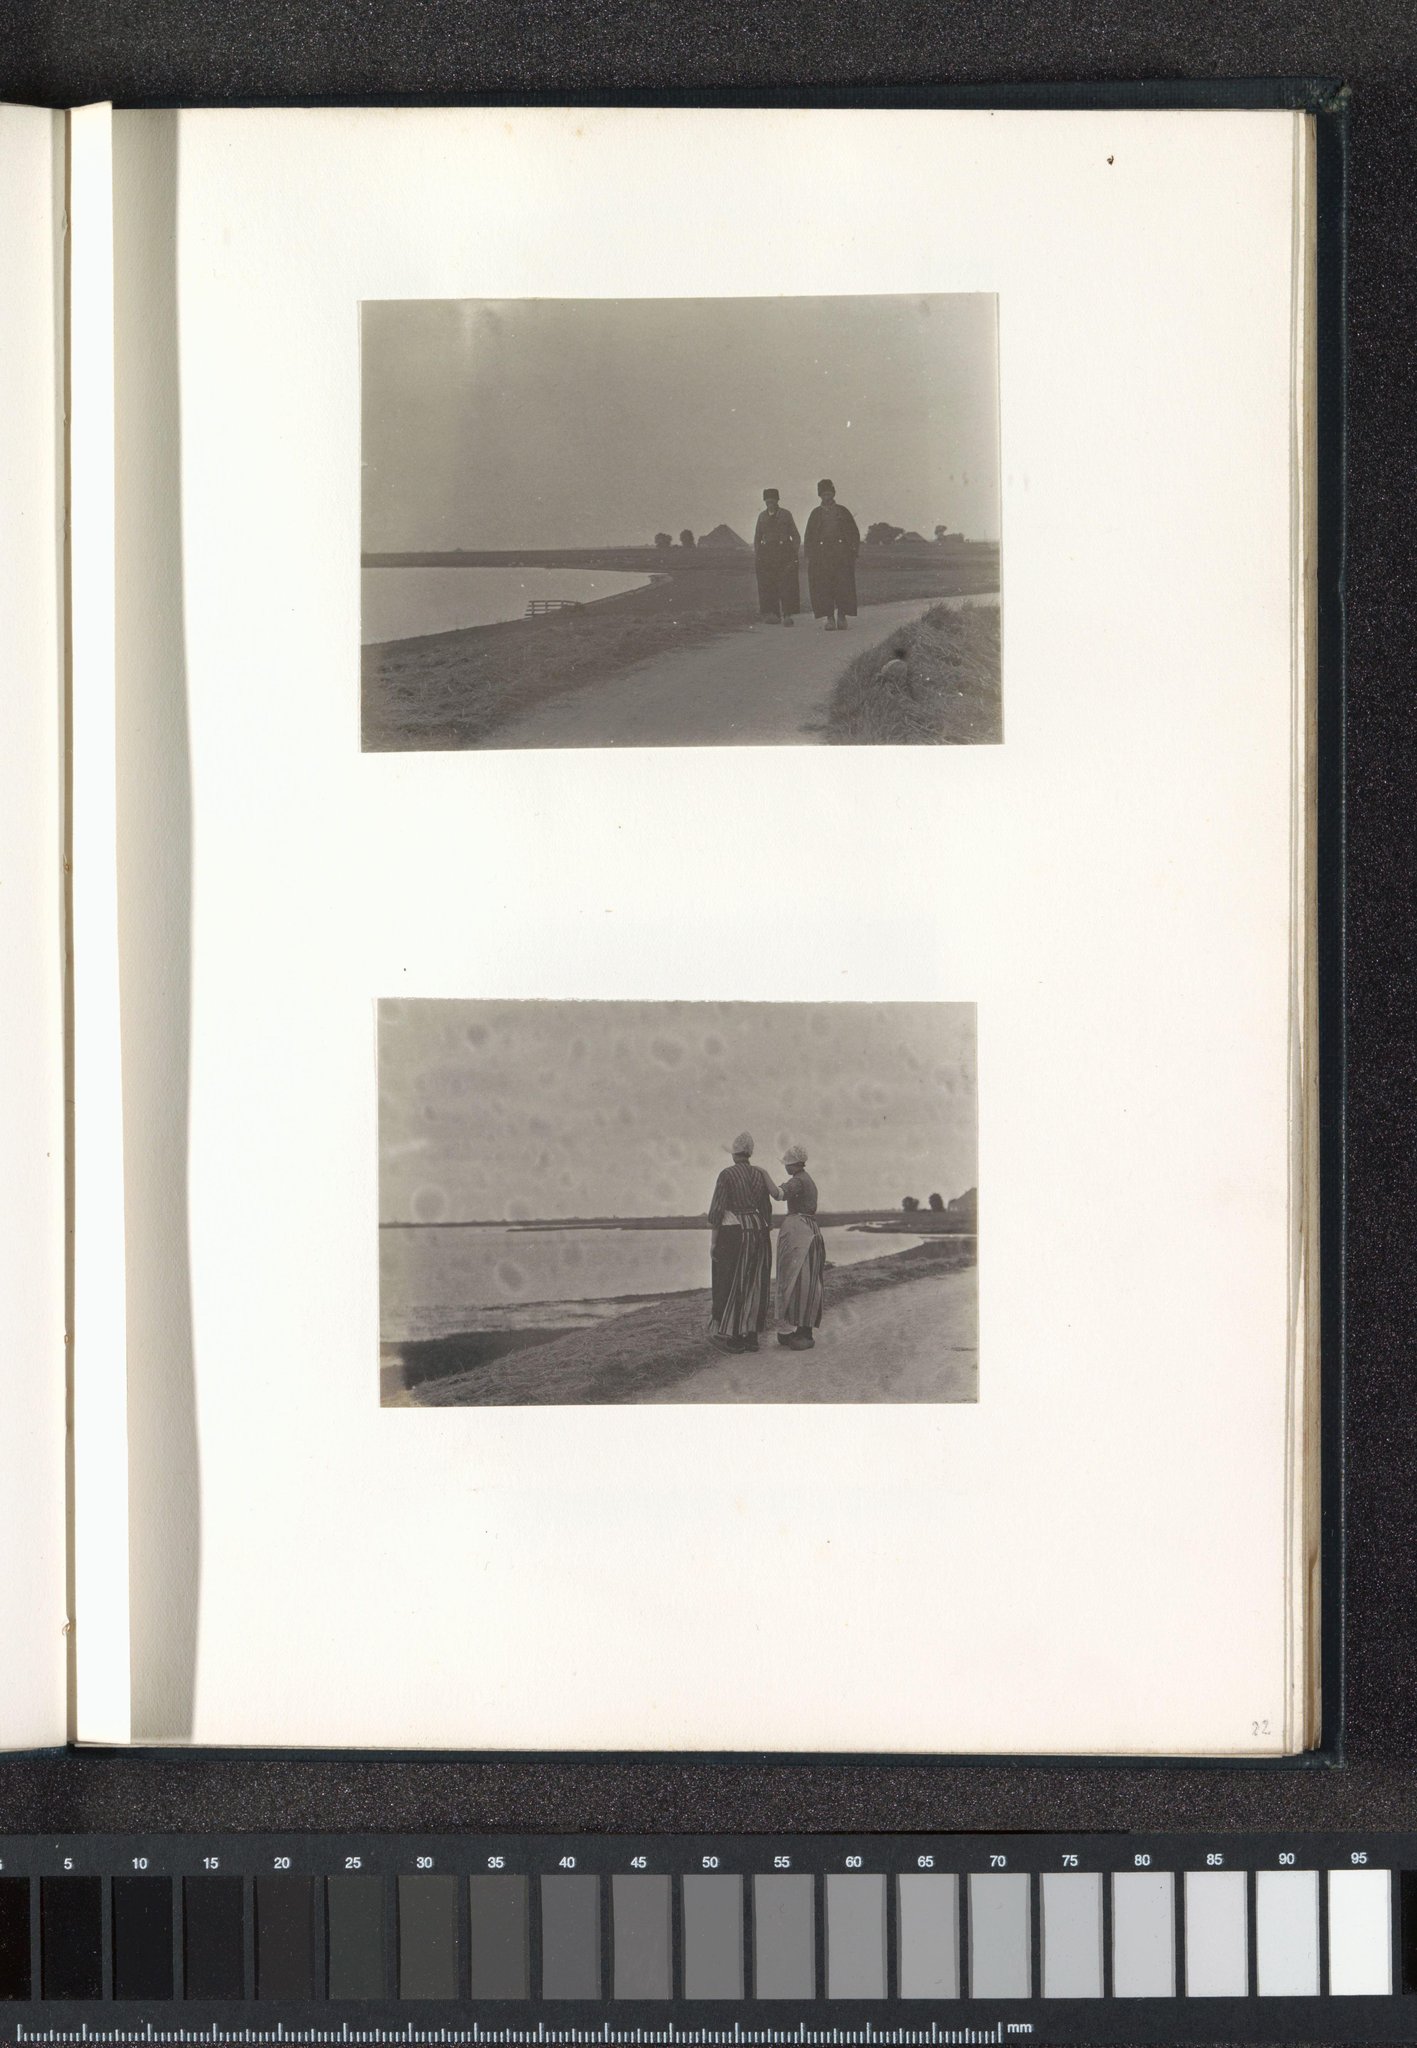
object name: photograph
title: Twee mannen in Volendamse klederdracht lopend op een dijk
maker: george hidderley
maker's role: fotograaf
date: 1900-1910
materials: paper, photographic support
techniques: gelatin silver print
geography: volendam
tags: folk costume, regional costume (+ men's clothes), dikes, levee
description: Onderdeel van fotoalbum met opnames van Volendam, Dordrecht, Gorinchem en Woudrichem.